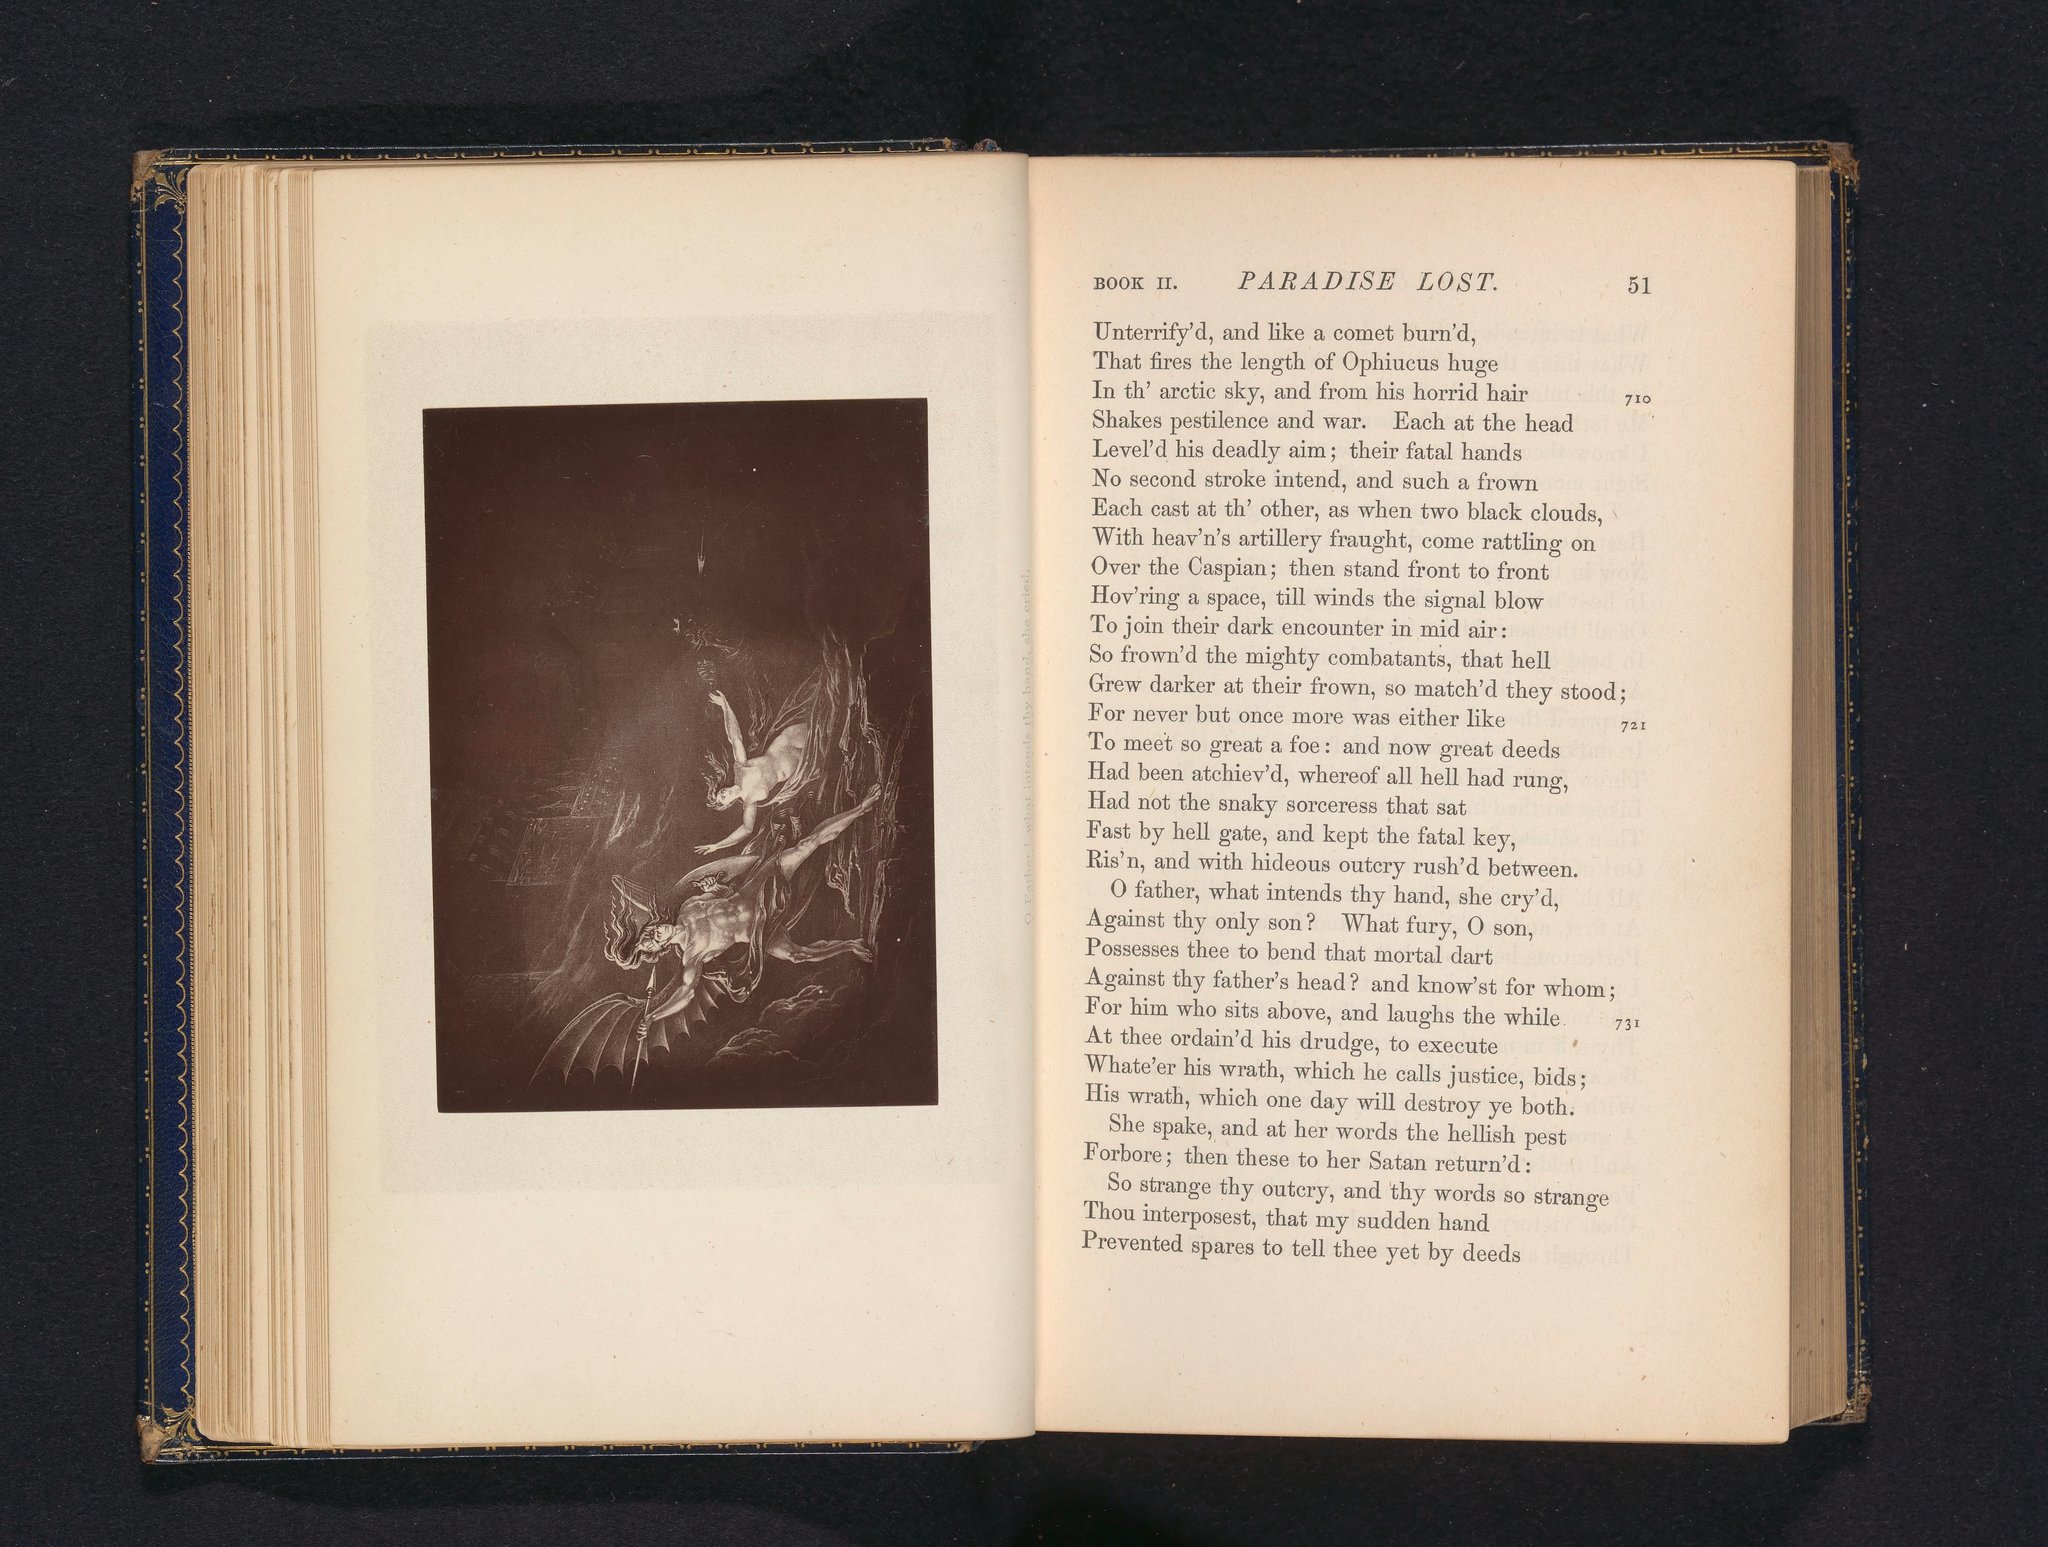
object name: photomechanical print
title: Fotoreproductie van een prent, voorstellende de Zonde werpt zich tussen Satan en de Dood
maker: Anonymous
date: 1866-1876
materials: paper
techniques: woodburytype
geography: united kingdom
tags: death as devilish being, hell and purgatory, devil(s) and demons: satan, vice, evil, sin; 'peccato' (ripa)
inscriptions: inscription: ‘O Father ! what intends thy hand, she cried, Against thy only son?-Bk. 2. l. 727.’